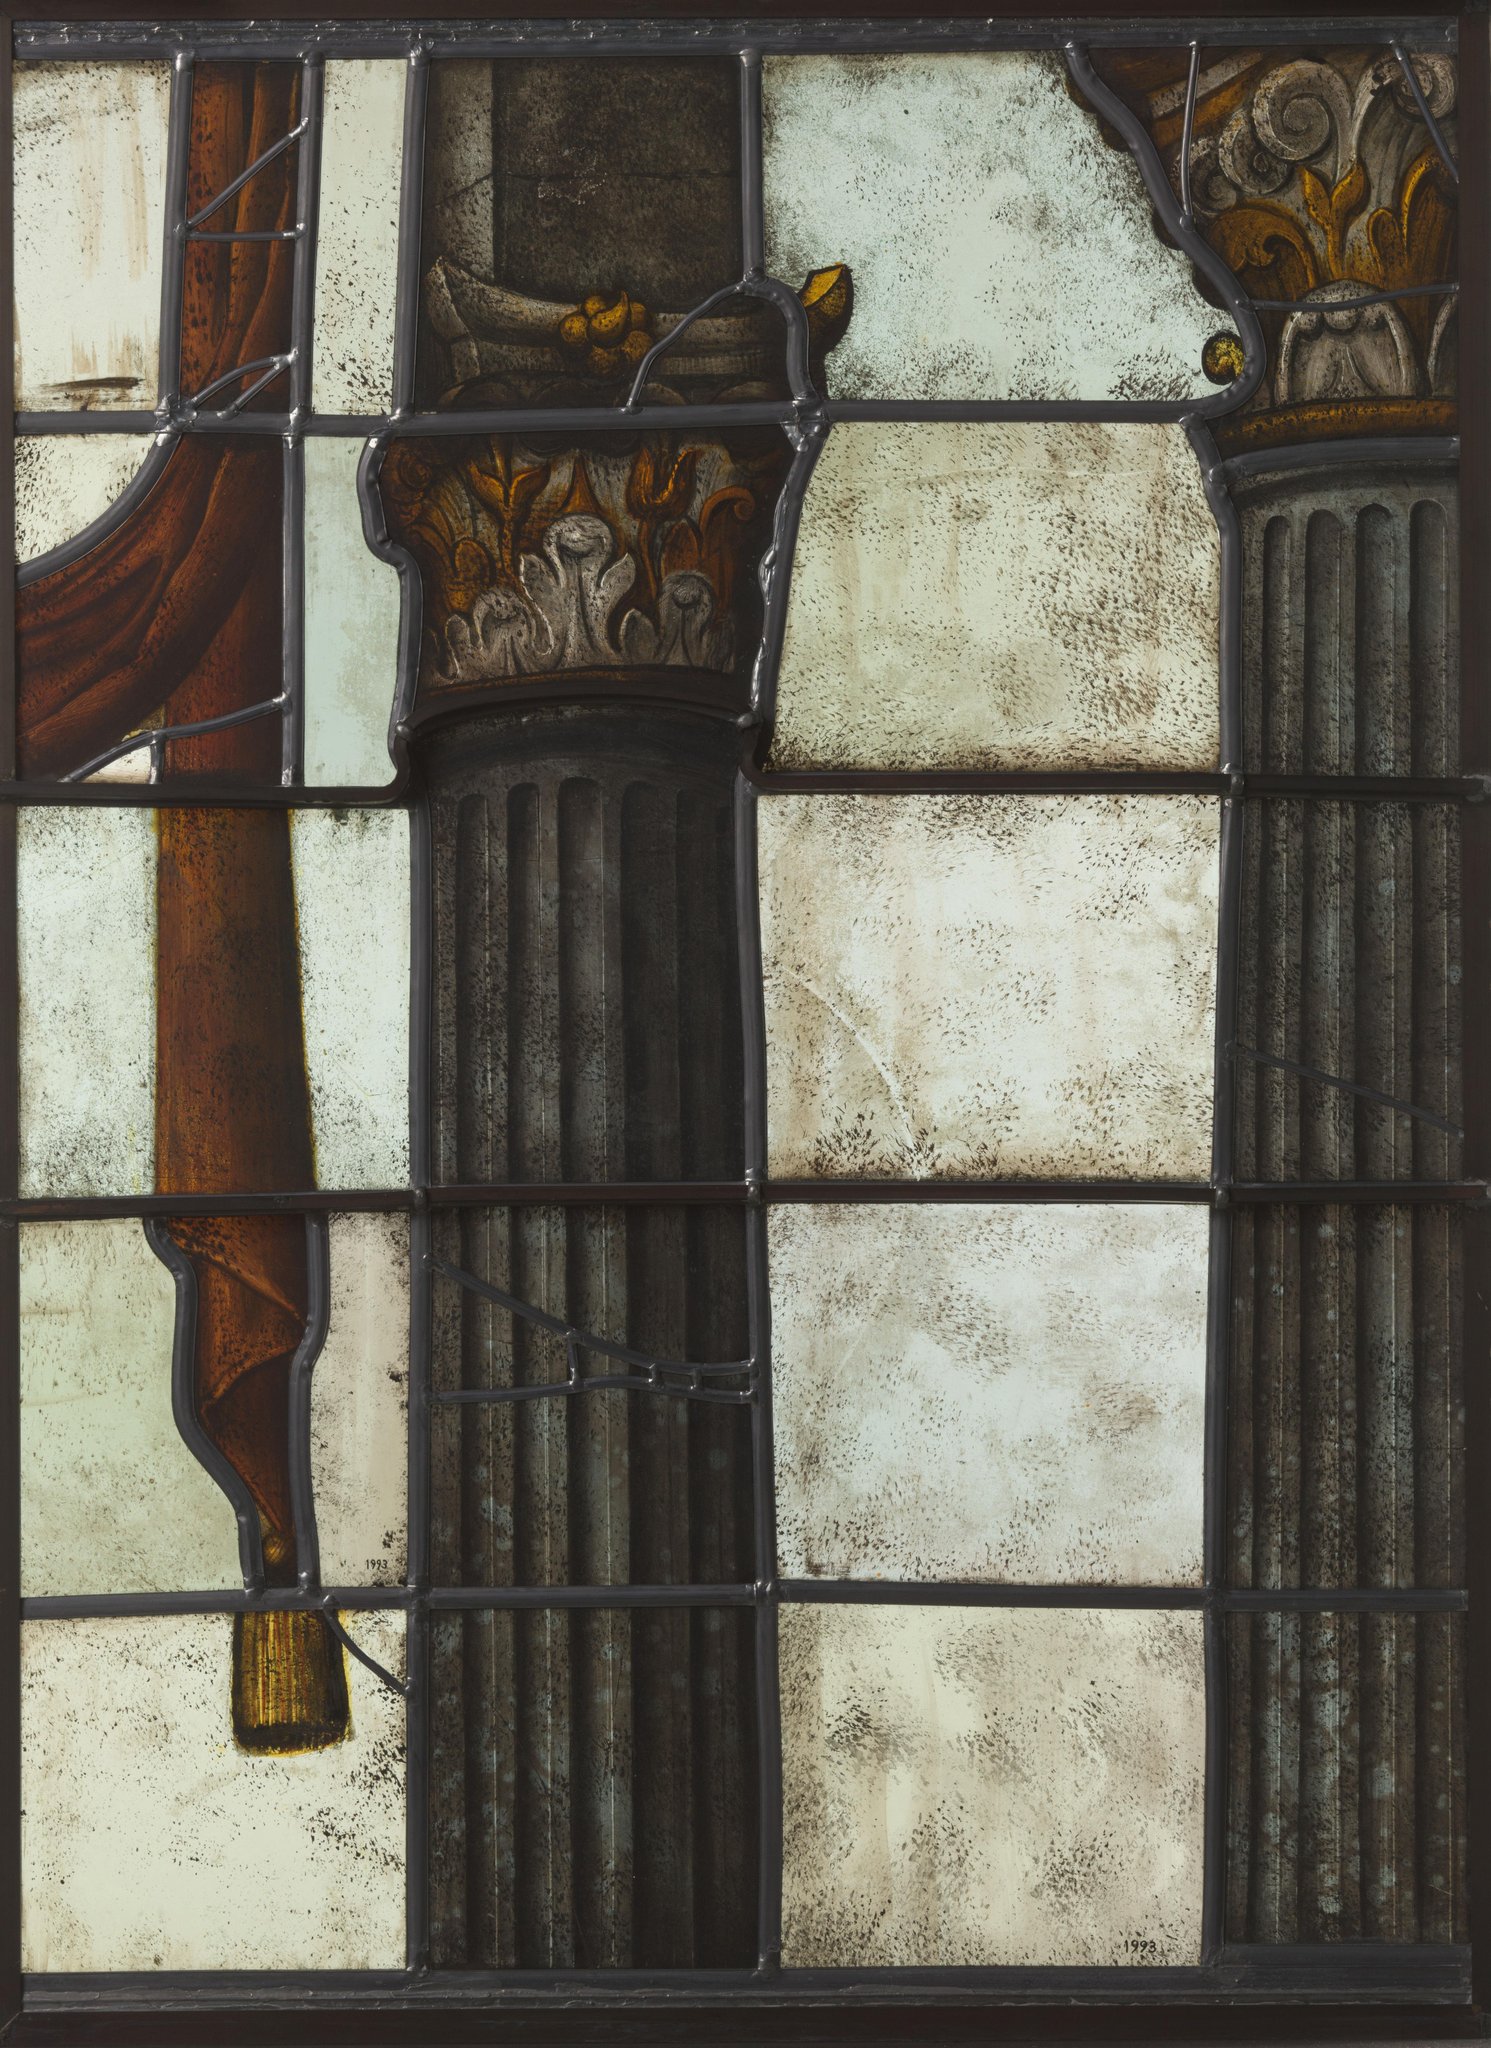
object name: light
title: Negende paneel van ruit met Prins Maurits in biddende houding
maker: Anonymous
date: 1618-1620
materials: glass, lead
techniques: leading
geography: netherlands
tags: the hague, maurice (prince of orange)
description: Groot raam afkomstig uit het klooster van St Agatha bij Cuyk. Prins Maurits in verguld harnas, met hermelijnen mantel en geplooide kraag, blootshoofds, in biddende houding, geknield op een bidstoel voor een lessenaar waarop een boek. De lessenaar staat op een tafel met een donkerblauw kleed met gouden franje gedekt. Helm en handschoenen liggen op de grond voor de tafel. De prins bevindt zich in een koepel door vier vrijstaande Korintische zuilen gedragen; boven zijn hoofd een baldakijn waaruit een lauwerkrans afhangt. De koepel wordt bekroond door het wapen van Maurits en het devies van de Orde van de Kousenband: 'Honi soit qui mal y pense' (Schande over hem die er kwaad van denkt). Wapen door twee lopende jongelingen gesteund. Het wapen leunt tegen het bovenstuk van de koepel. Onder dit tafereel bevinden zich brokstukken architectuur die onoordeelkundig zijn aangebracht. Rechts ligt een jonge vrouw geknield met opgeheven handen. Zij draagt een geel zijden mantel met hermelijn omzoomd. Het gezicht is in olieverf bijgemaakt in 1891.